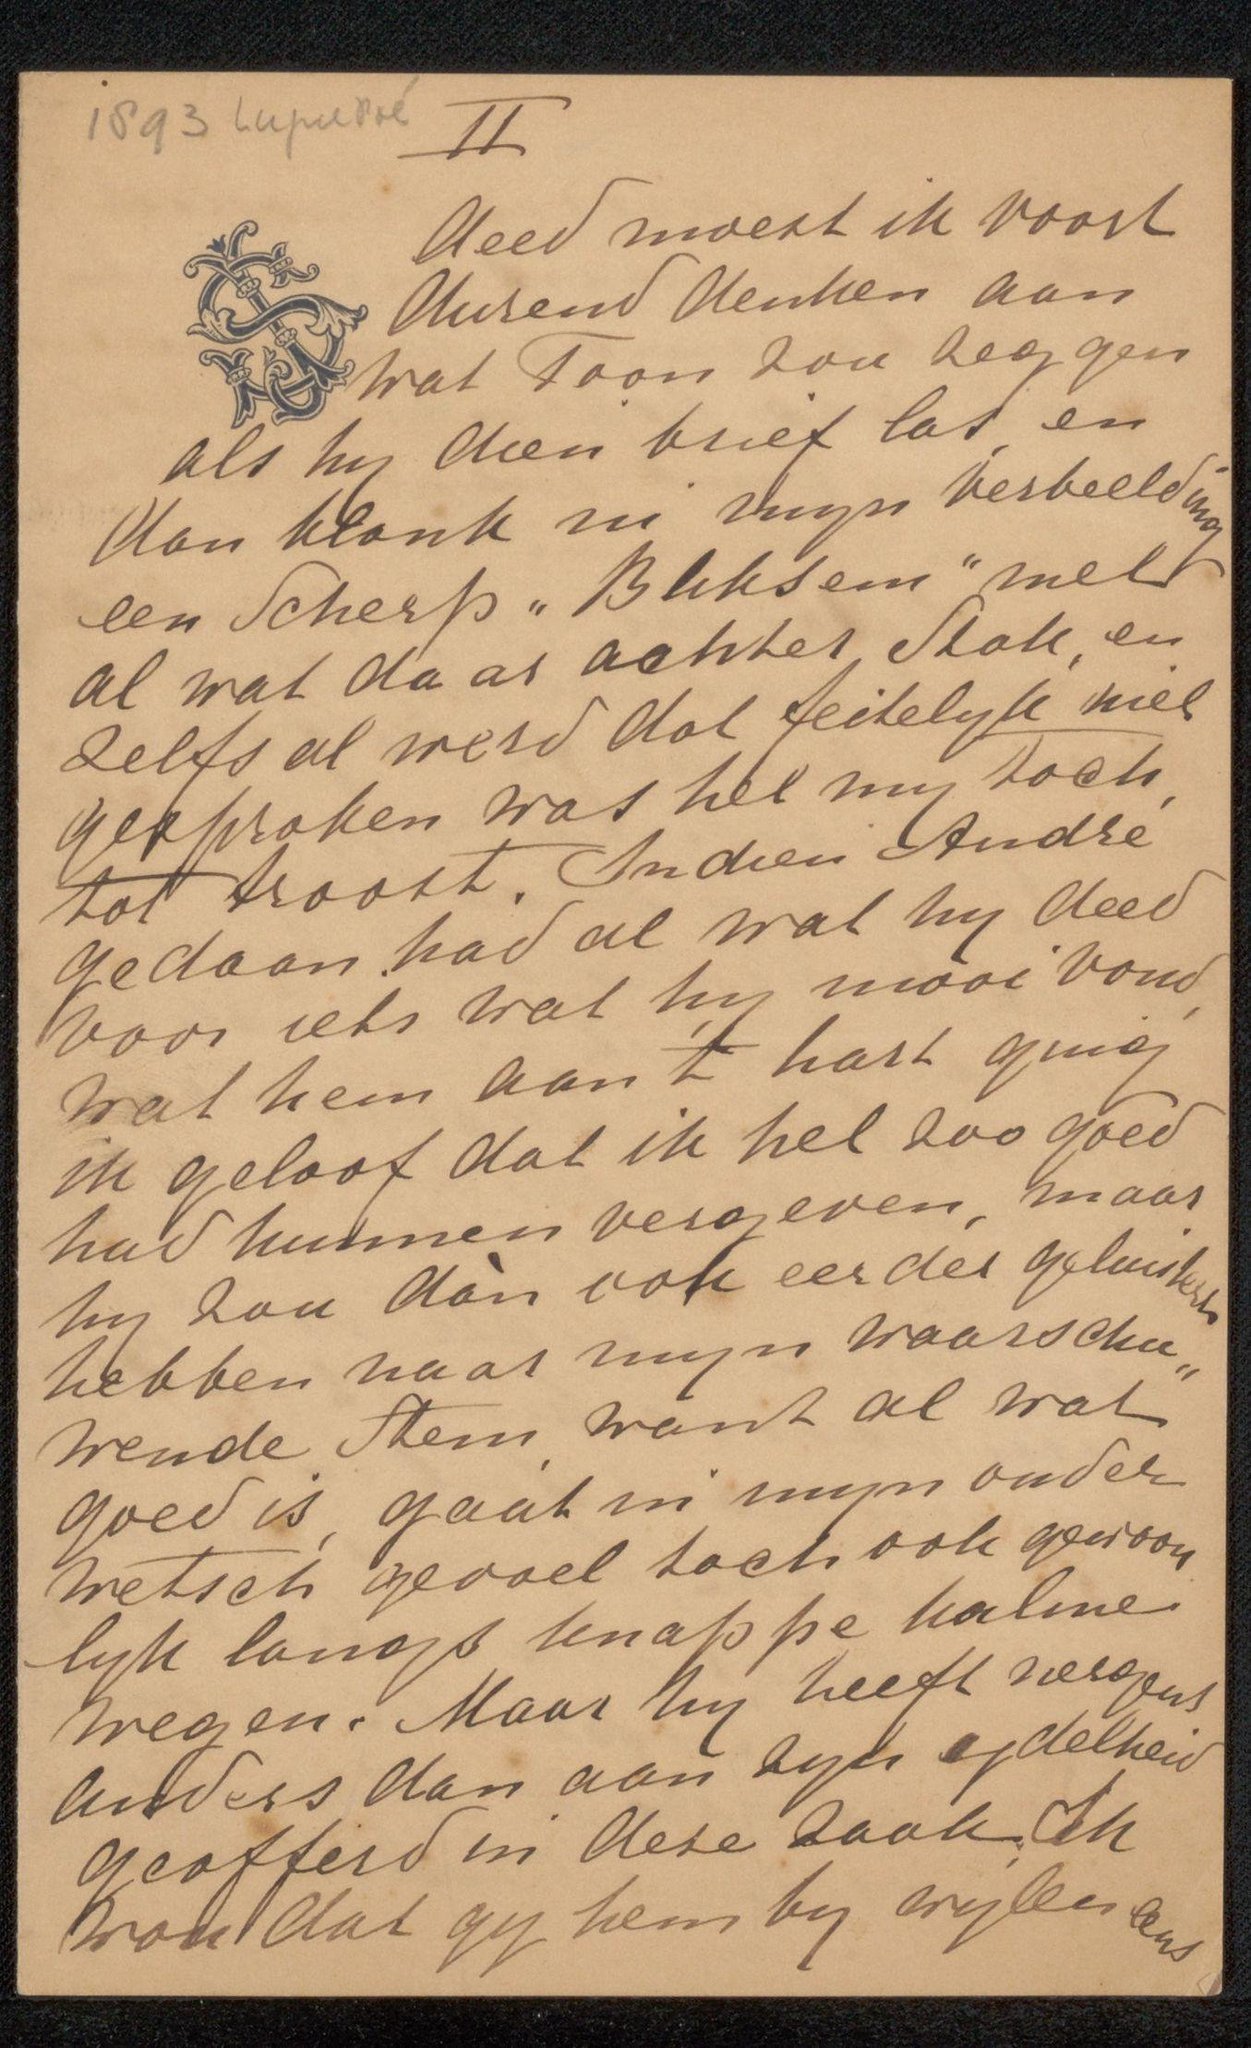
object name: letter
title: Brief aan Jan Veth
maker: jacoba cornelia jolles-singels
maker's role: schrijver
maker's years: 1847-1901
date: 1874-1901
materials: ink, paper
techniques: pen, writing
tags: designer, jan veth, den bosch, amsterdam, painter, print maker, draughtsman, antoon derkinderen, utrecht, antonie cornelis loffelt, paris, lugné-poe, rotterdam, herman heijermans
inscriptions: monogram: ‘JS’, collector's mark: ‘RPK’